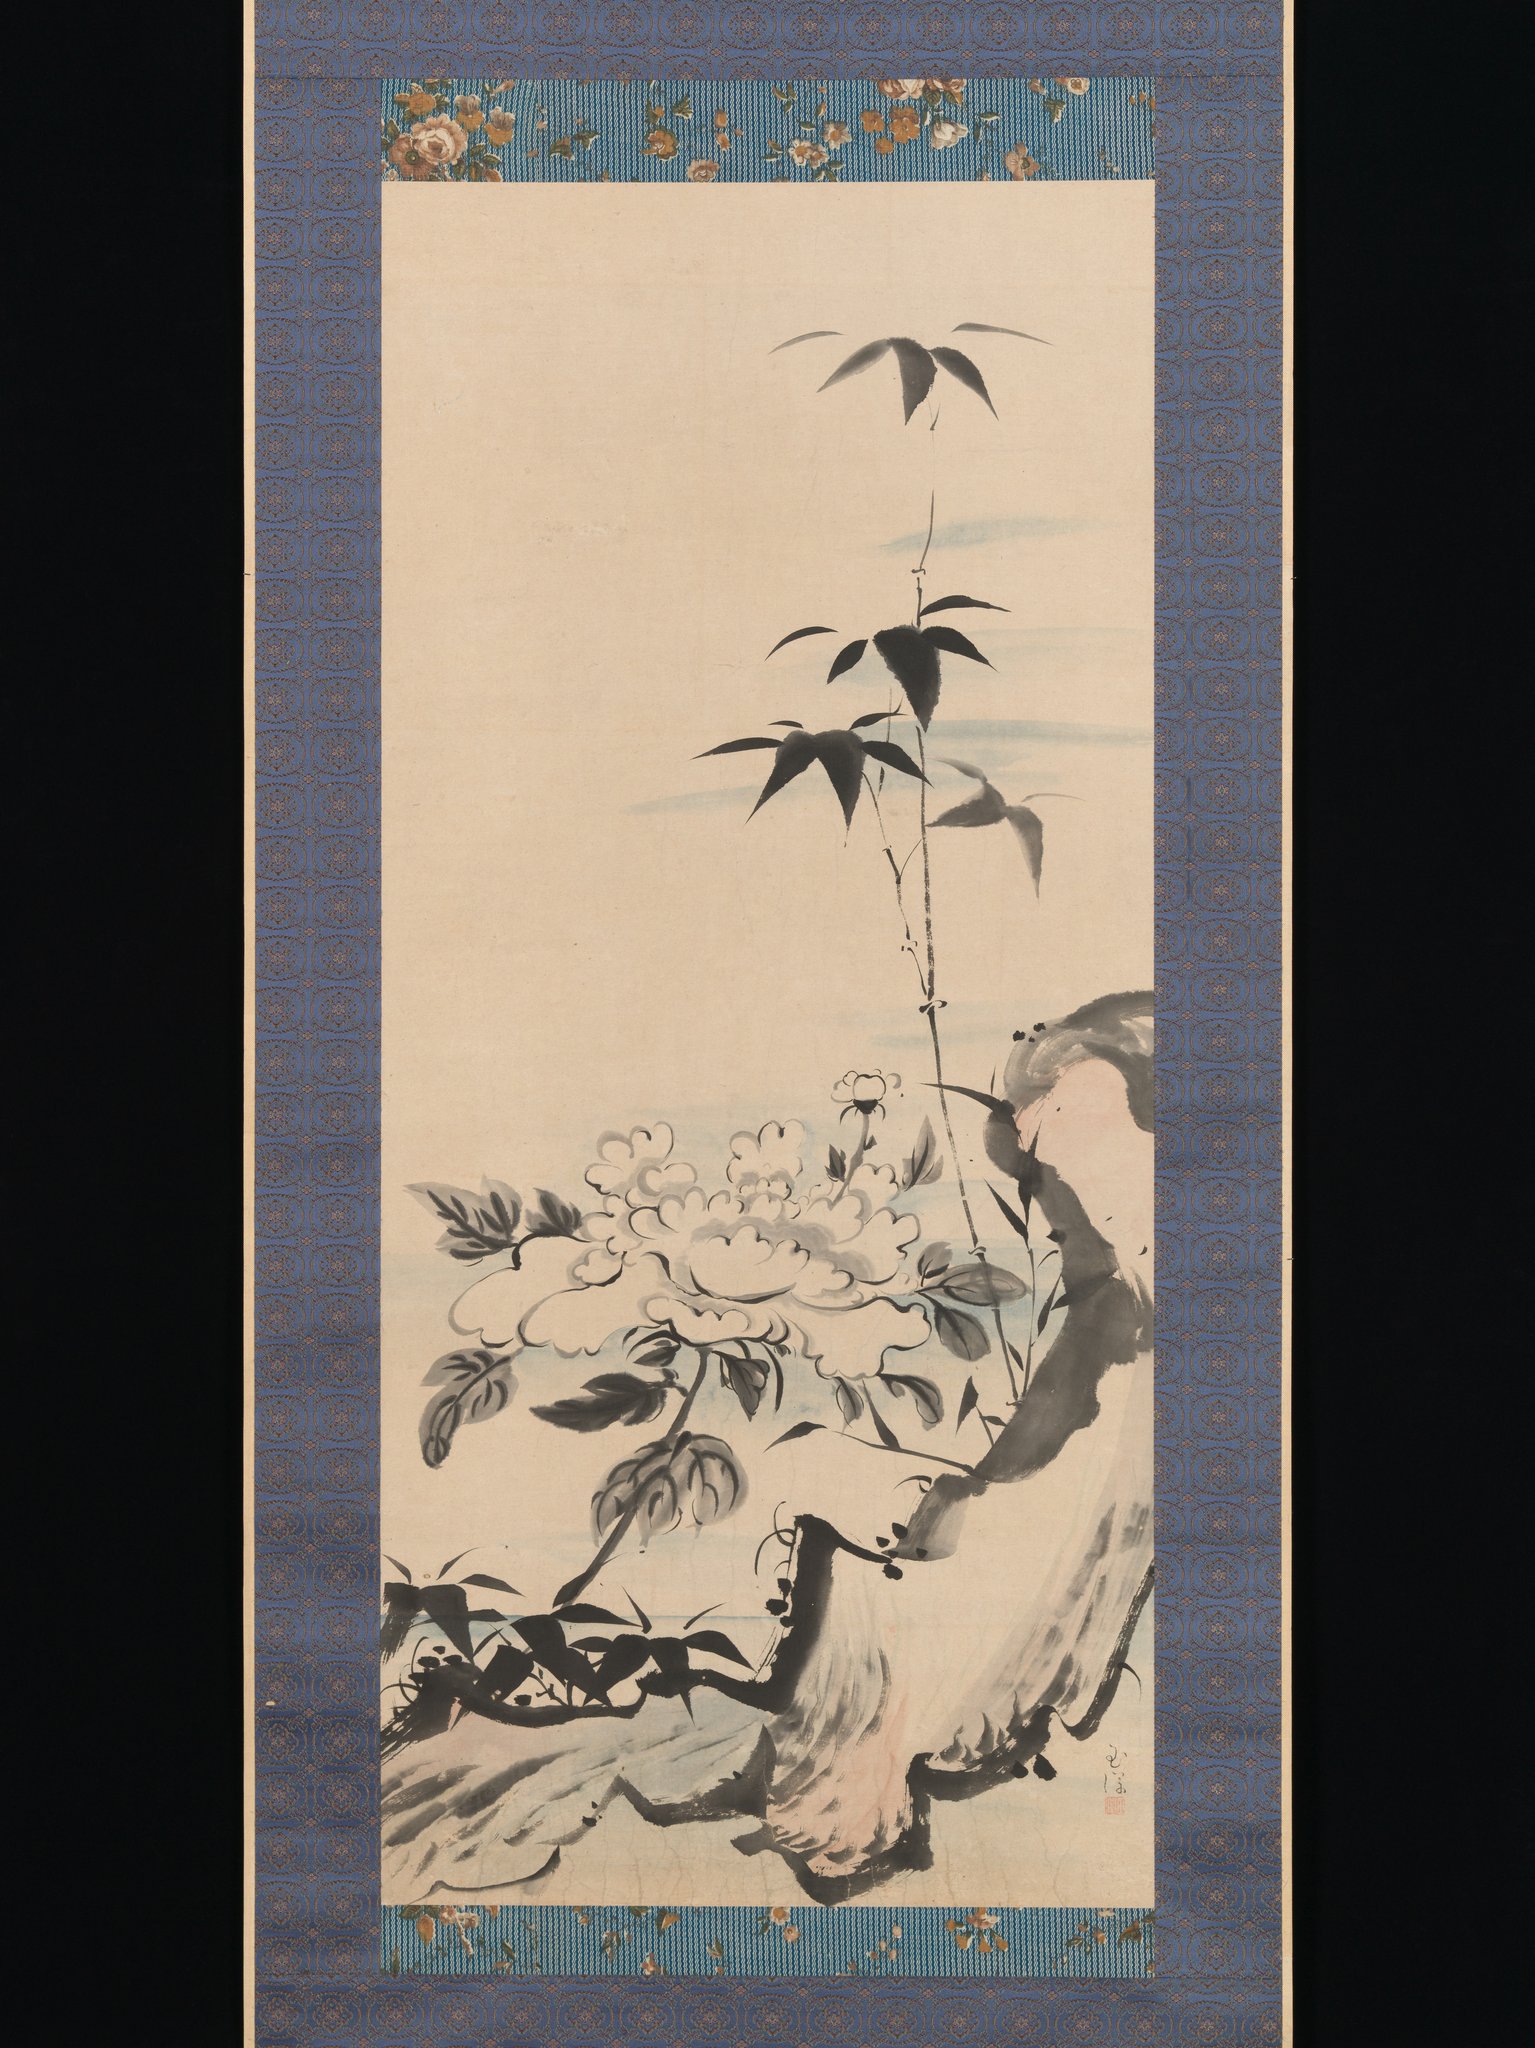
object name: hanging scroll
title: Peony and Bamboo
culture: japanese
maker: ike (tokuyama) gyokuran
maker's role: artist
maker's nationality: japanese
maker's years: 1728-1784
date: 1768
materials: ink, paper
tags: peonies,bamboo